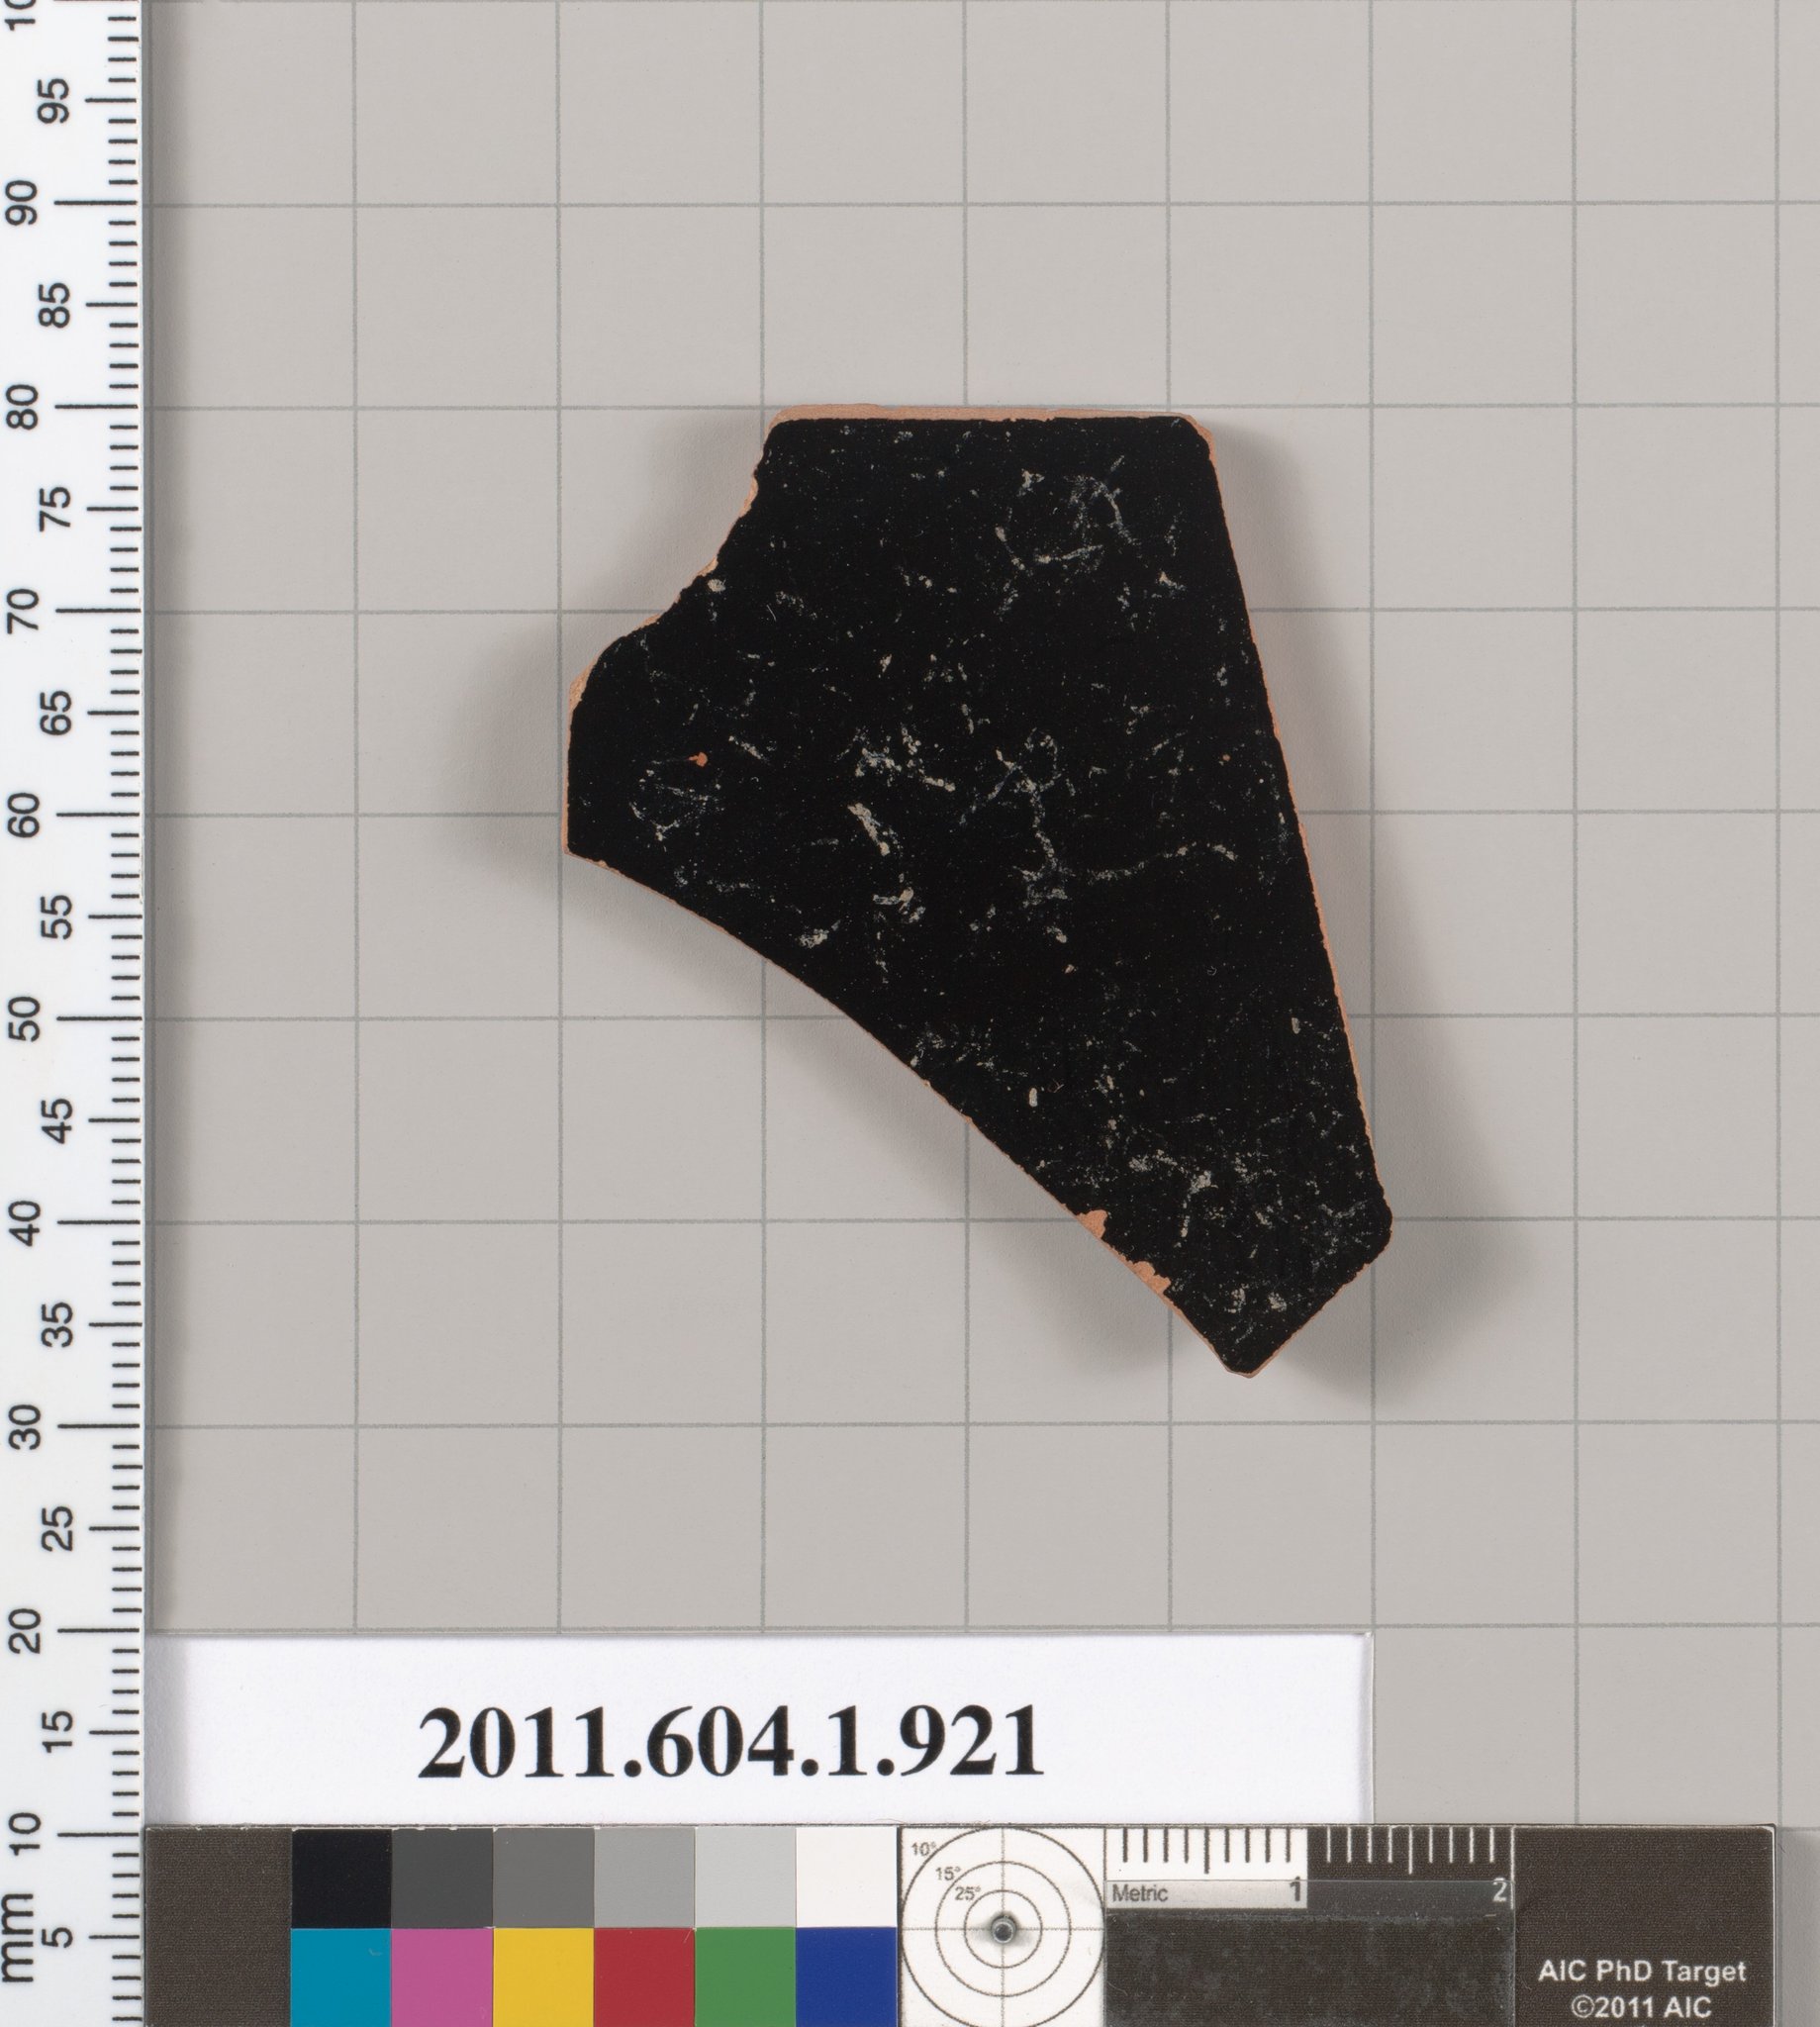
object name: stemless cup or plate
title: Terracotta fragment of a stemless cup or plate?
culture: greek, attic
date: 434-401 BCE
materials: terracotta